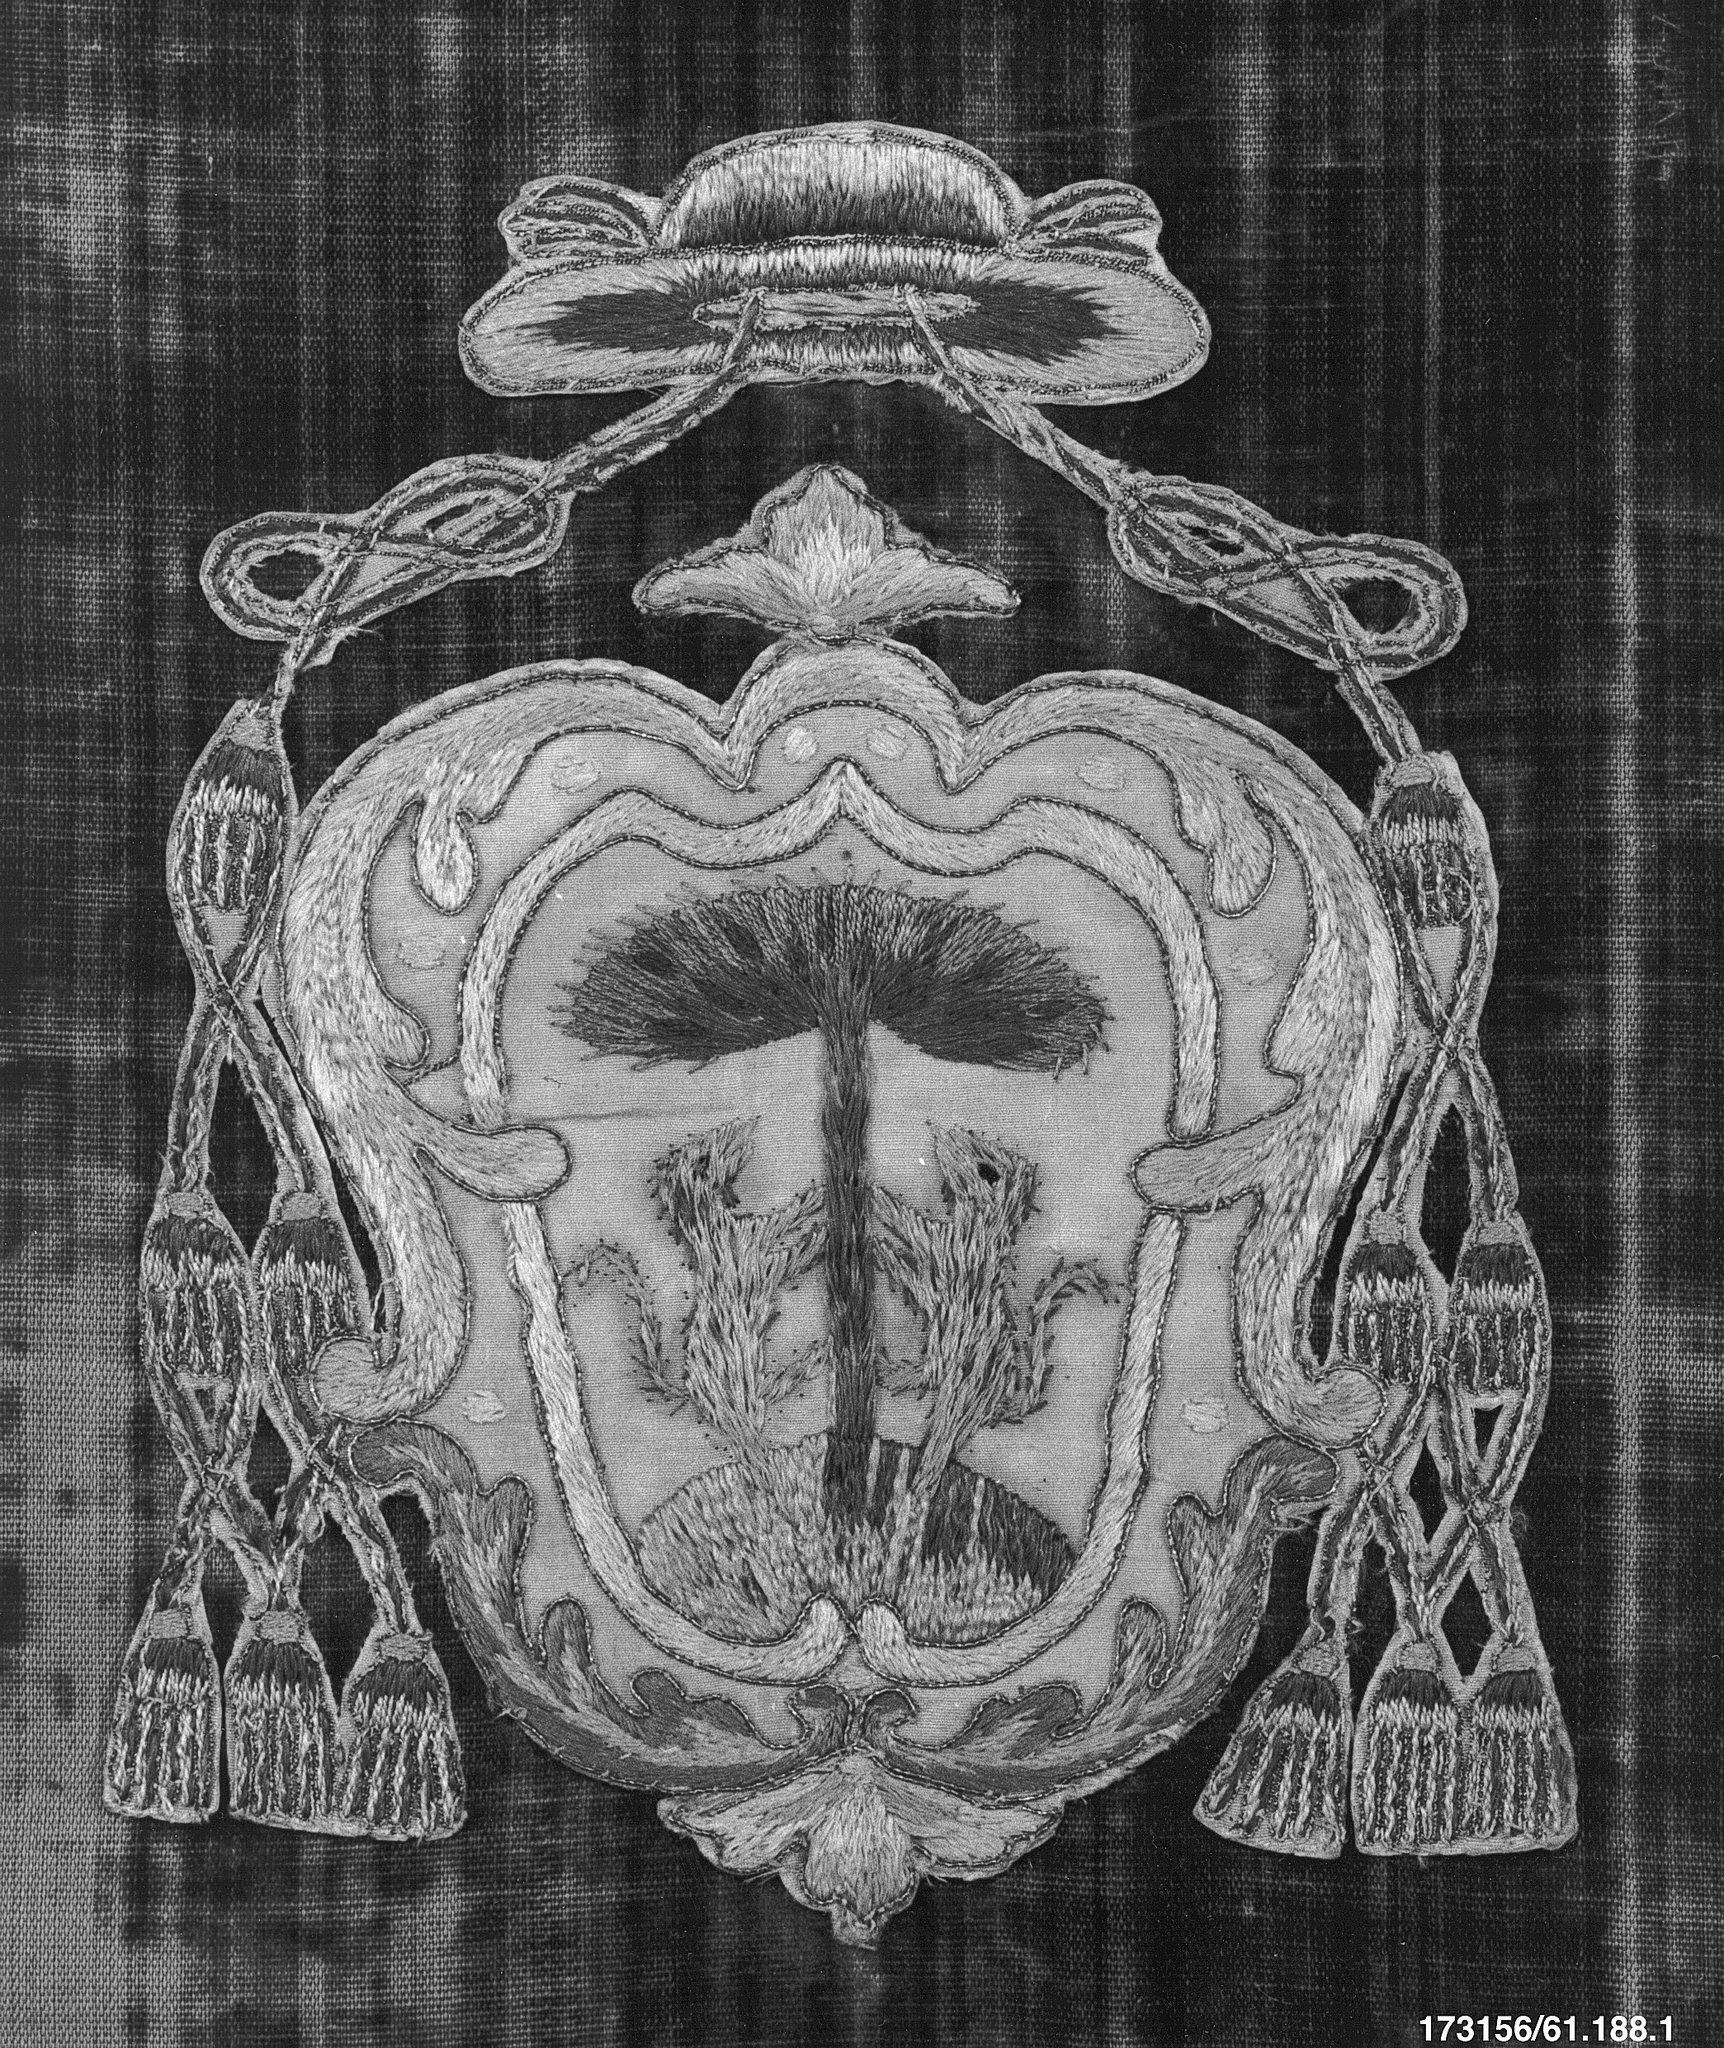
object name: coat of arm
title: Coat of arms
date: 1601-1700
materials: metal thread, silk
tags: coat of arms